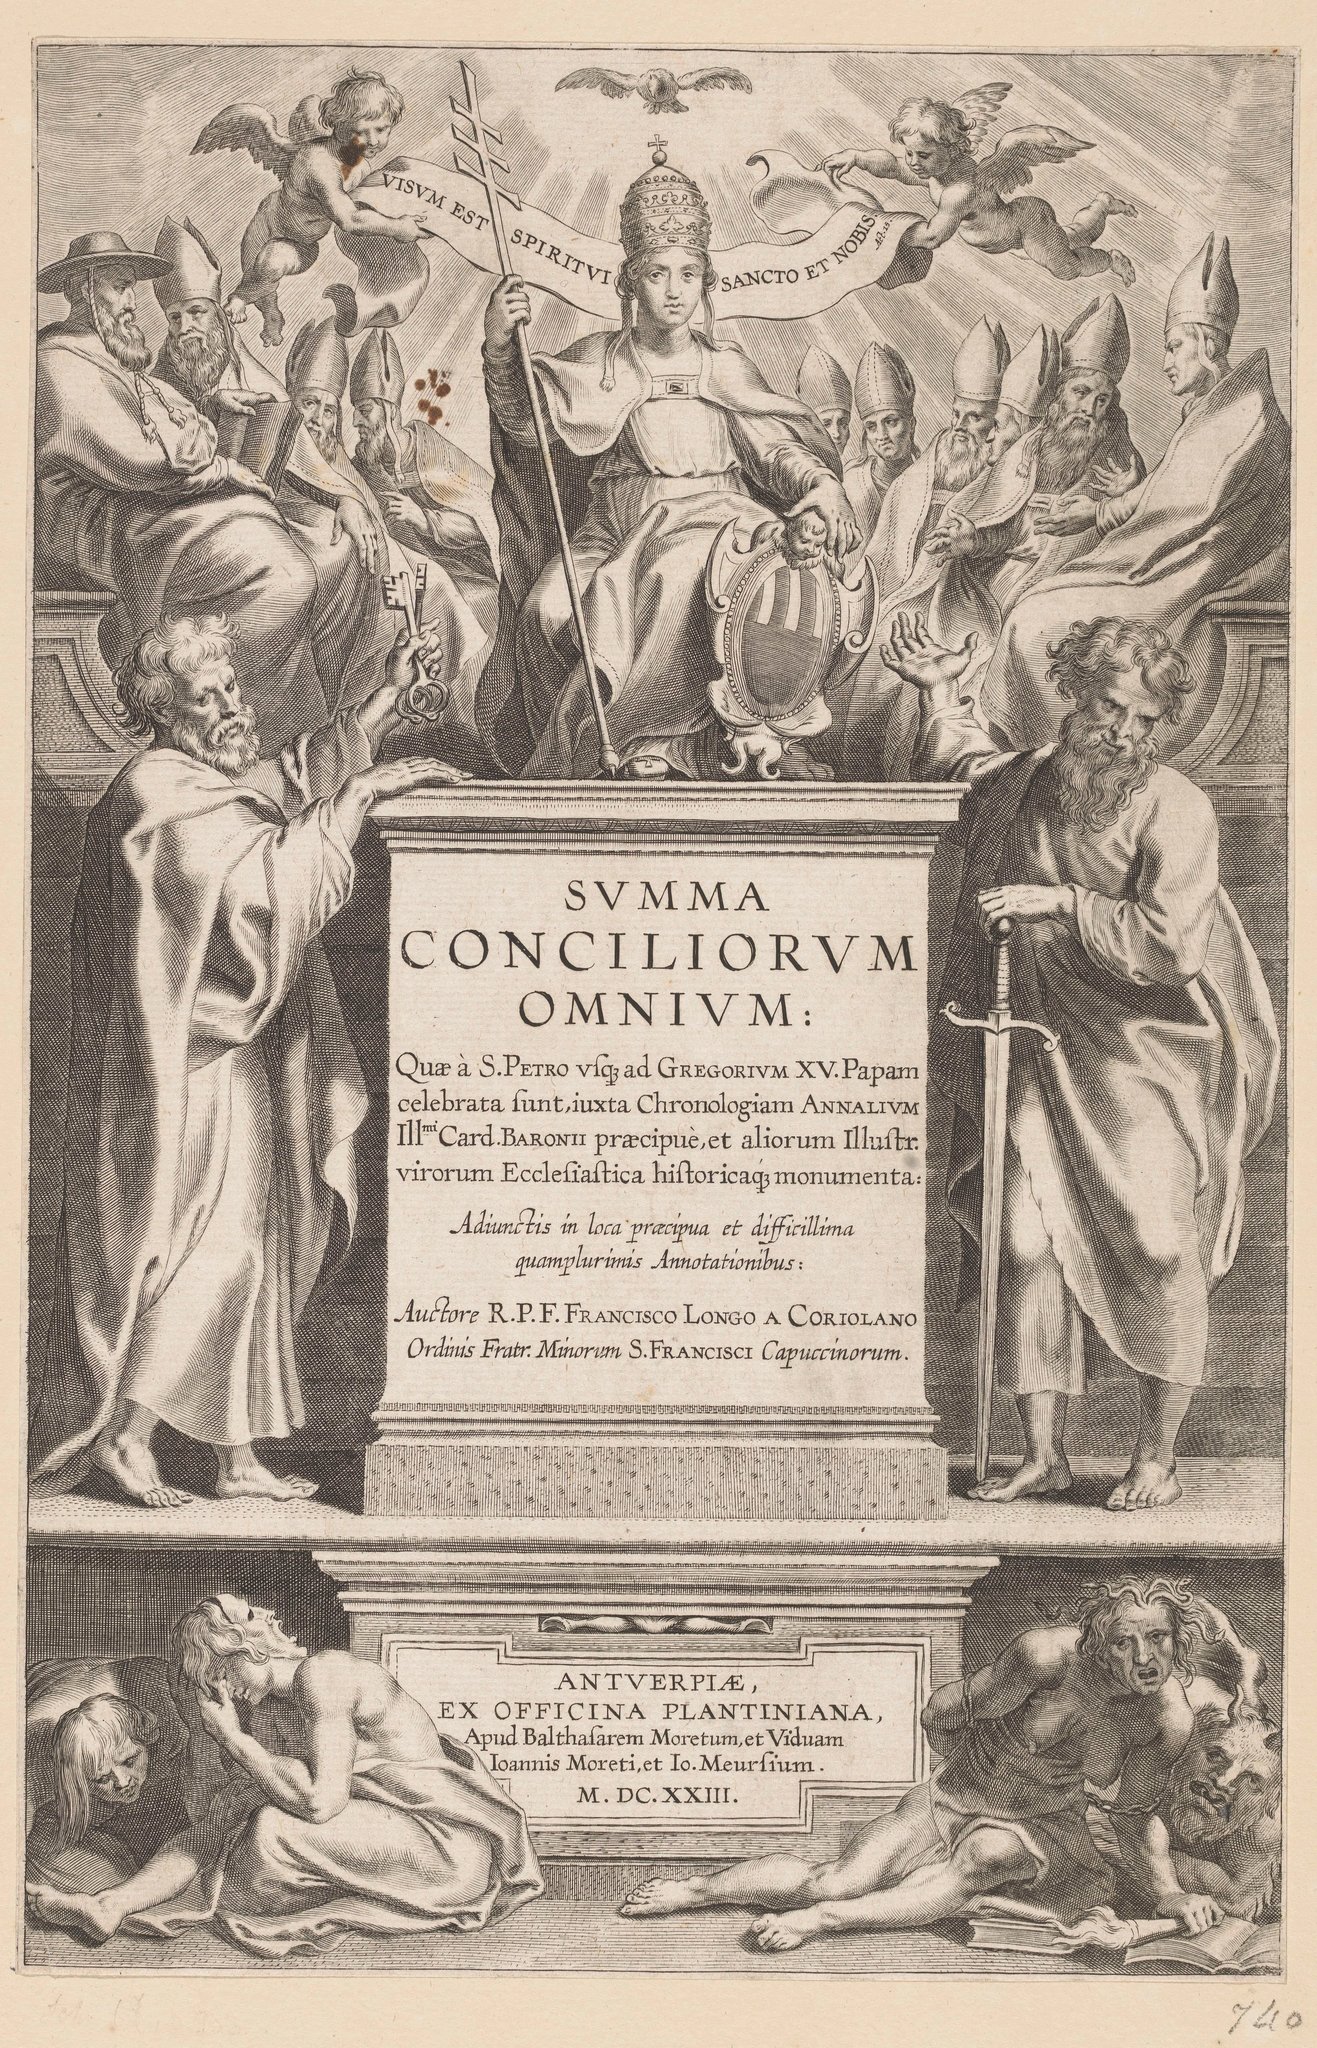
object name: titelblad, titelpagina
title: Allegorische titelpagina met vrouwelijke personificatie van het pausdom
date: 1623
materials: paper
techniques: engraving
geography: antwerp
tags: council, synod ~ roman catholic church, heresy; 'heresia' (ripa), cheat, deceit; 'fraude', 'inganno' (ripa) (+ personification), (allegory on) papacy and apostolic succession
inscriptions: collector's mark: Lugt 240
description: Op een piëdestal troont de vrouwelijke personificatie van het pausdom met tiara en het wapen van Gregorius XV tussen bisschoppen en kardinalen. Aan weerszijden van het piëdestal de heiligen Petrus en Paulus. Onder het vloerniveau personificaties van Ketterij en Fraude.